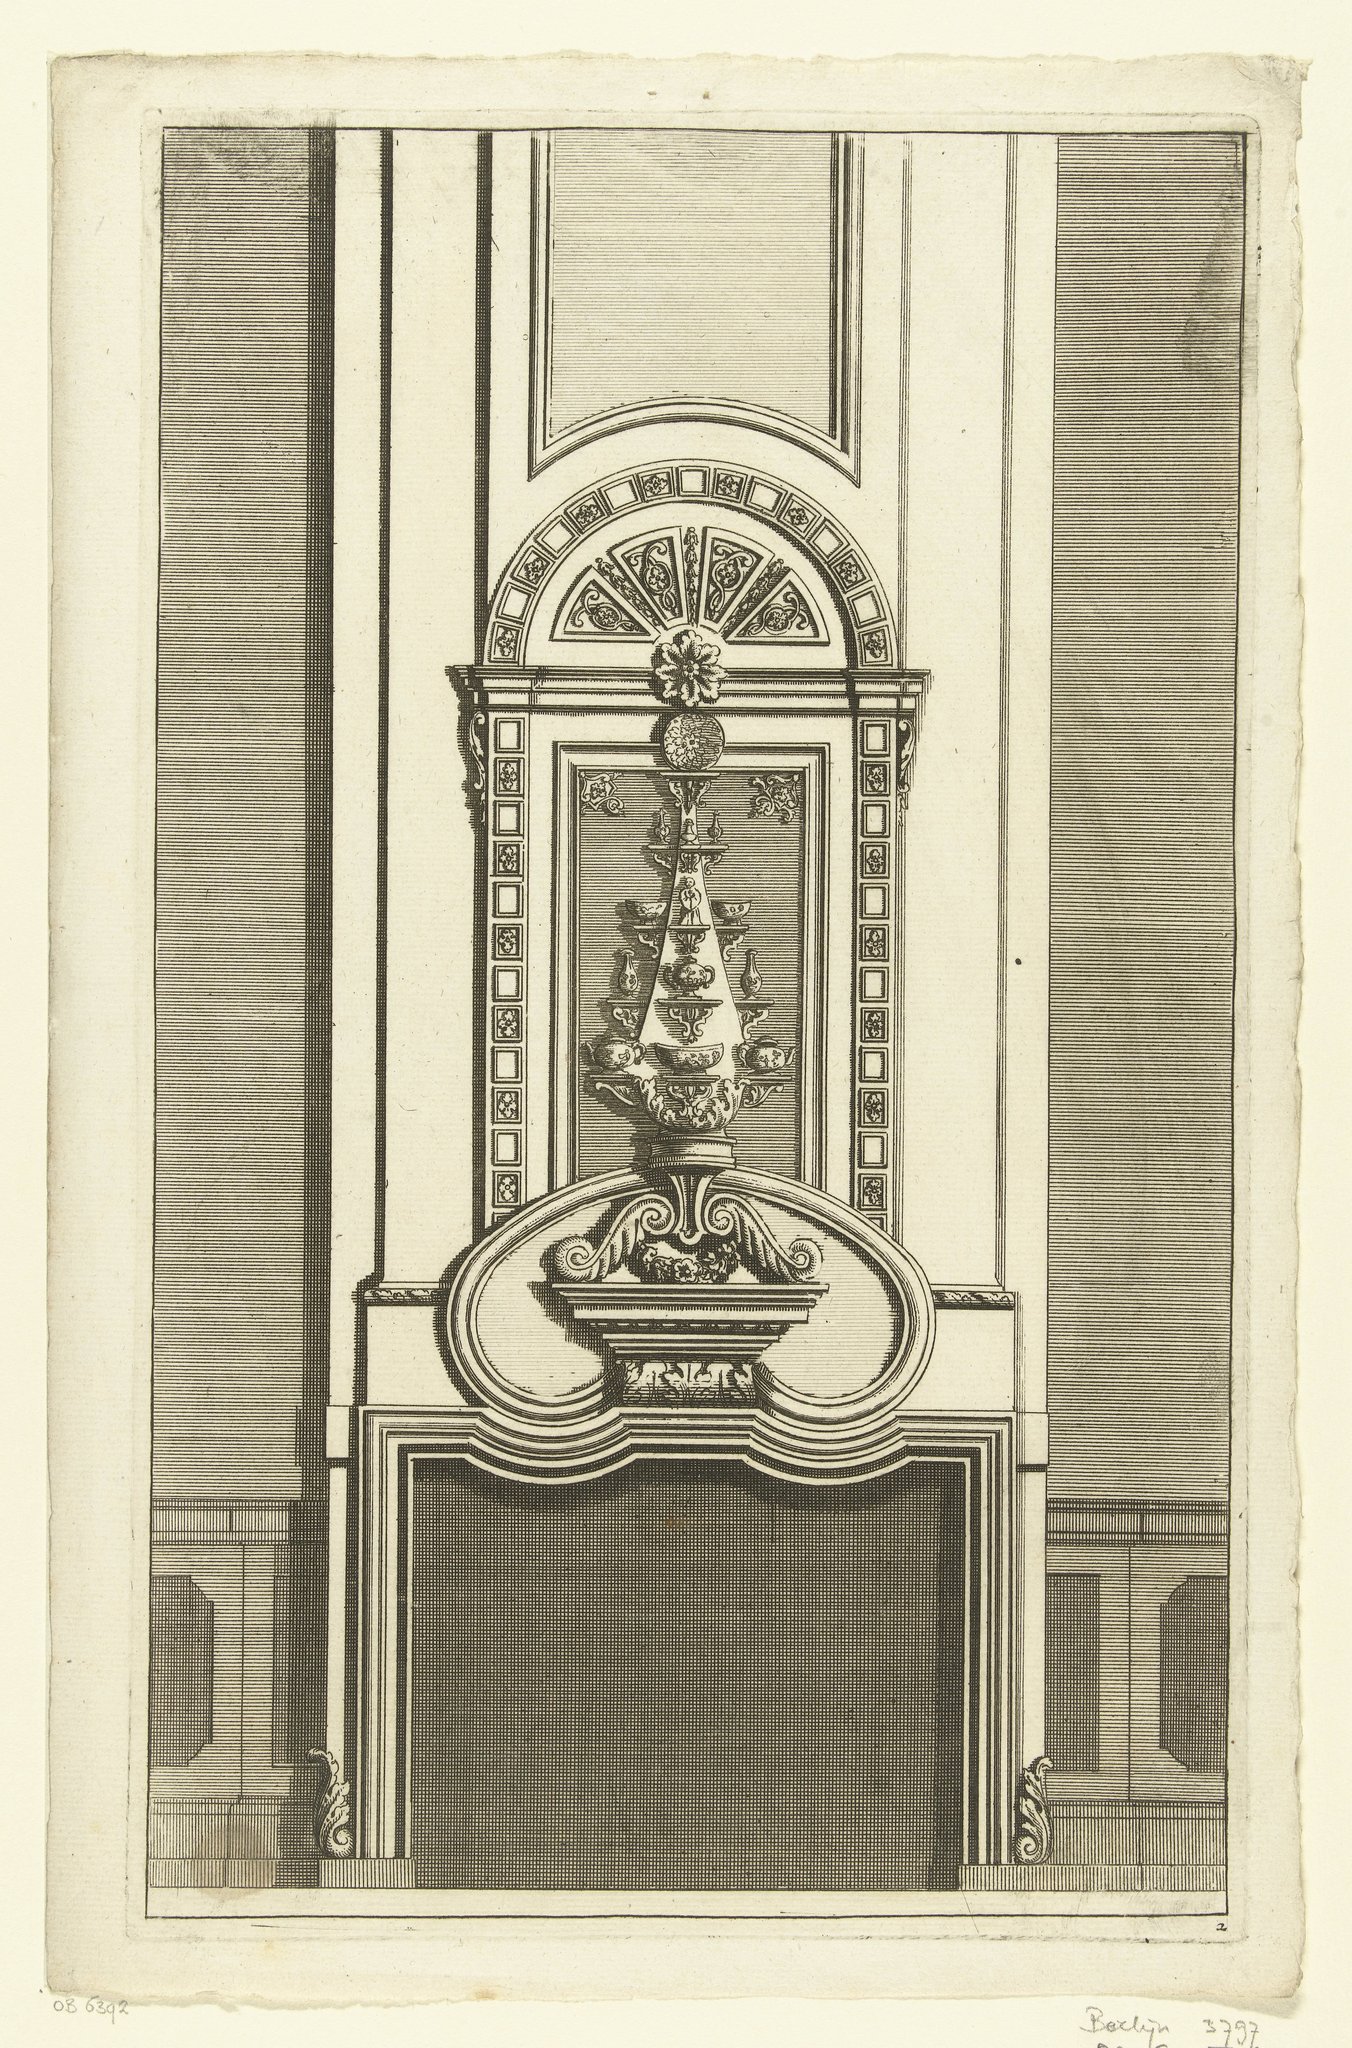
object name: ornament print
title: Schoorsteenmantelstegen een 'lambris d'appui'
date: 1680-1700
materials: paper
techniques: etching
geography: amsterdam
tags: mirror, chimney-piece, mantelpiece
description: Schoorsteenmantel met een tablet in de vorm van een fragment van een architraaf waarop twee consoles die een obelisk ondersteunen. Obelisk heeft consoles waarop Chinees porselein staat. Achter de obelisk een spiegel. No. 2 uit serie.